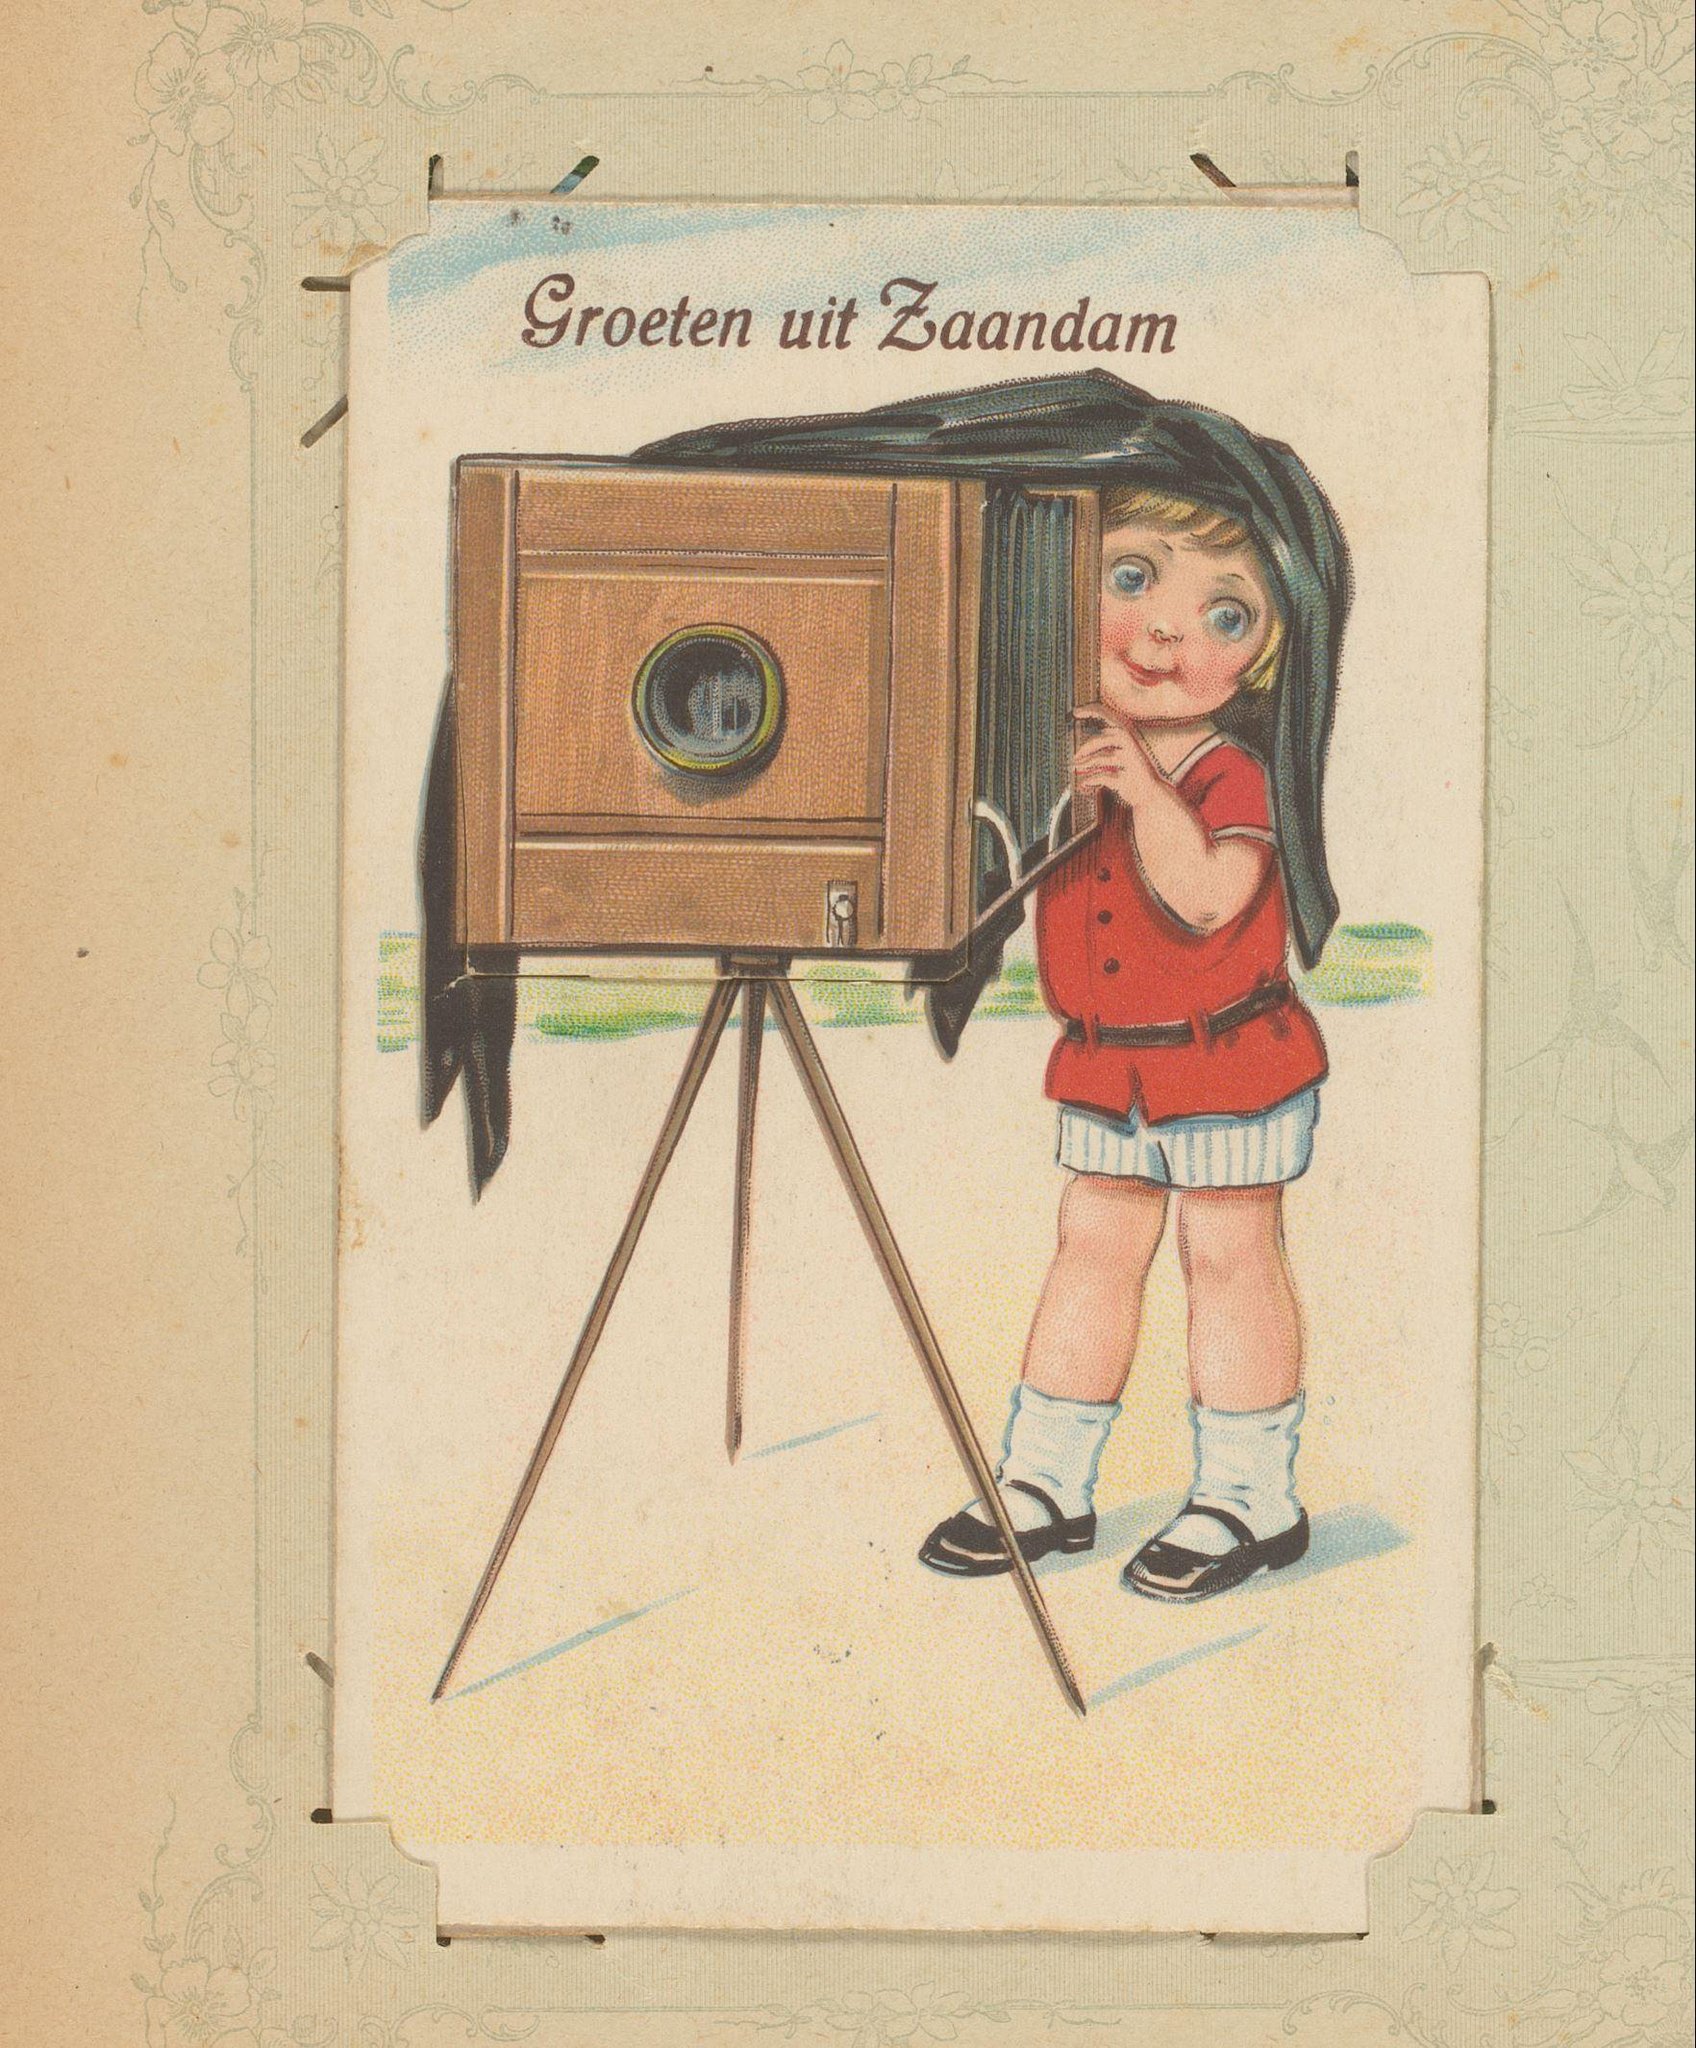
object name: photomechanical print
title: Groeten uit Zaandam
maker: Anonymous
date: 1900-1950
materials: cardboard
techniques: chromolithography, photograph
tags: adult woman, camera ~ photography, taking photographs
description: Prentbriefkaart met onder de camera een opgeplakte leporello met tien gezichten op Zaandam, onder meer op het Stadhuis, de Wilhelminasluis en de Hembrug. Deze prent maakt deel uit van een album.